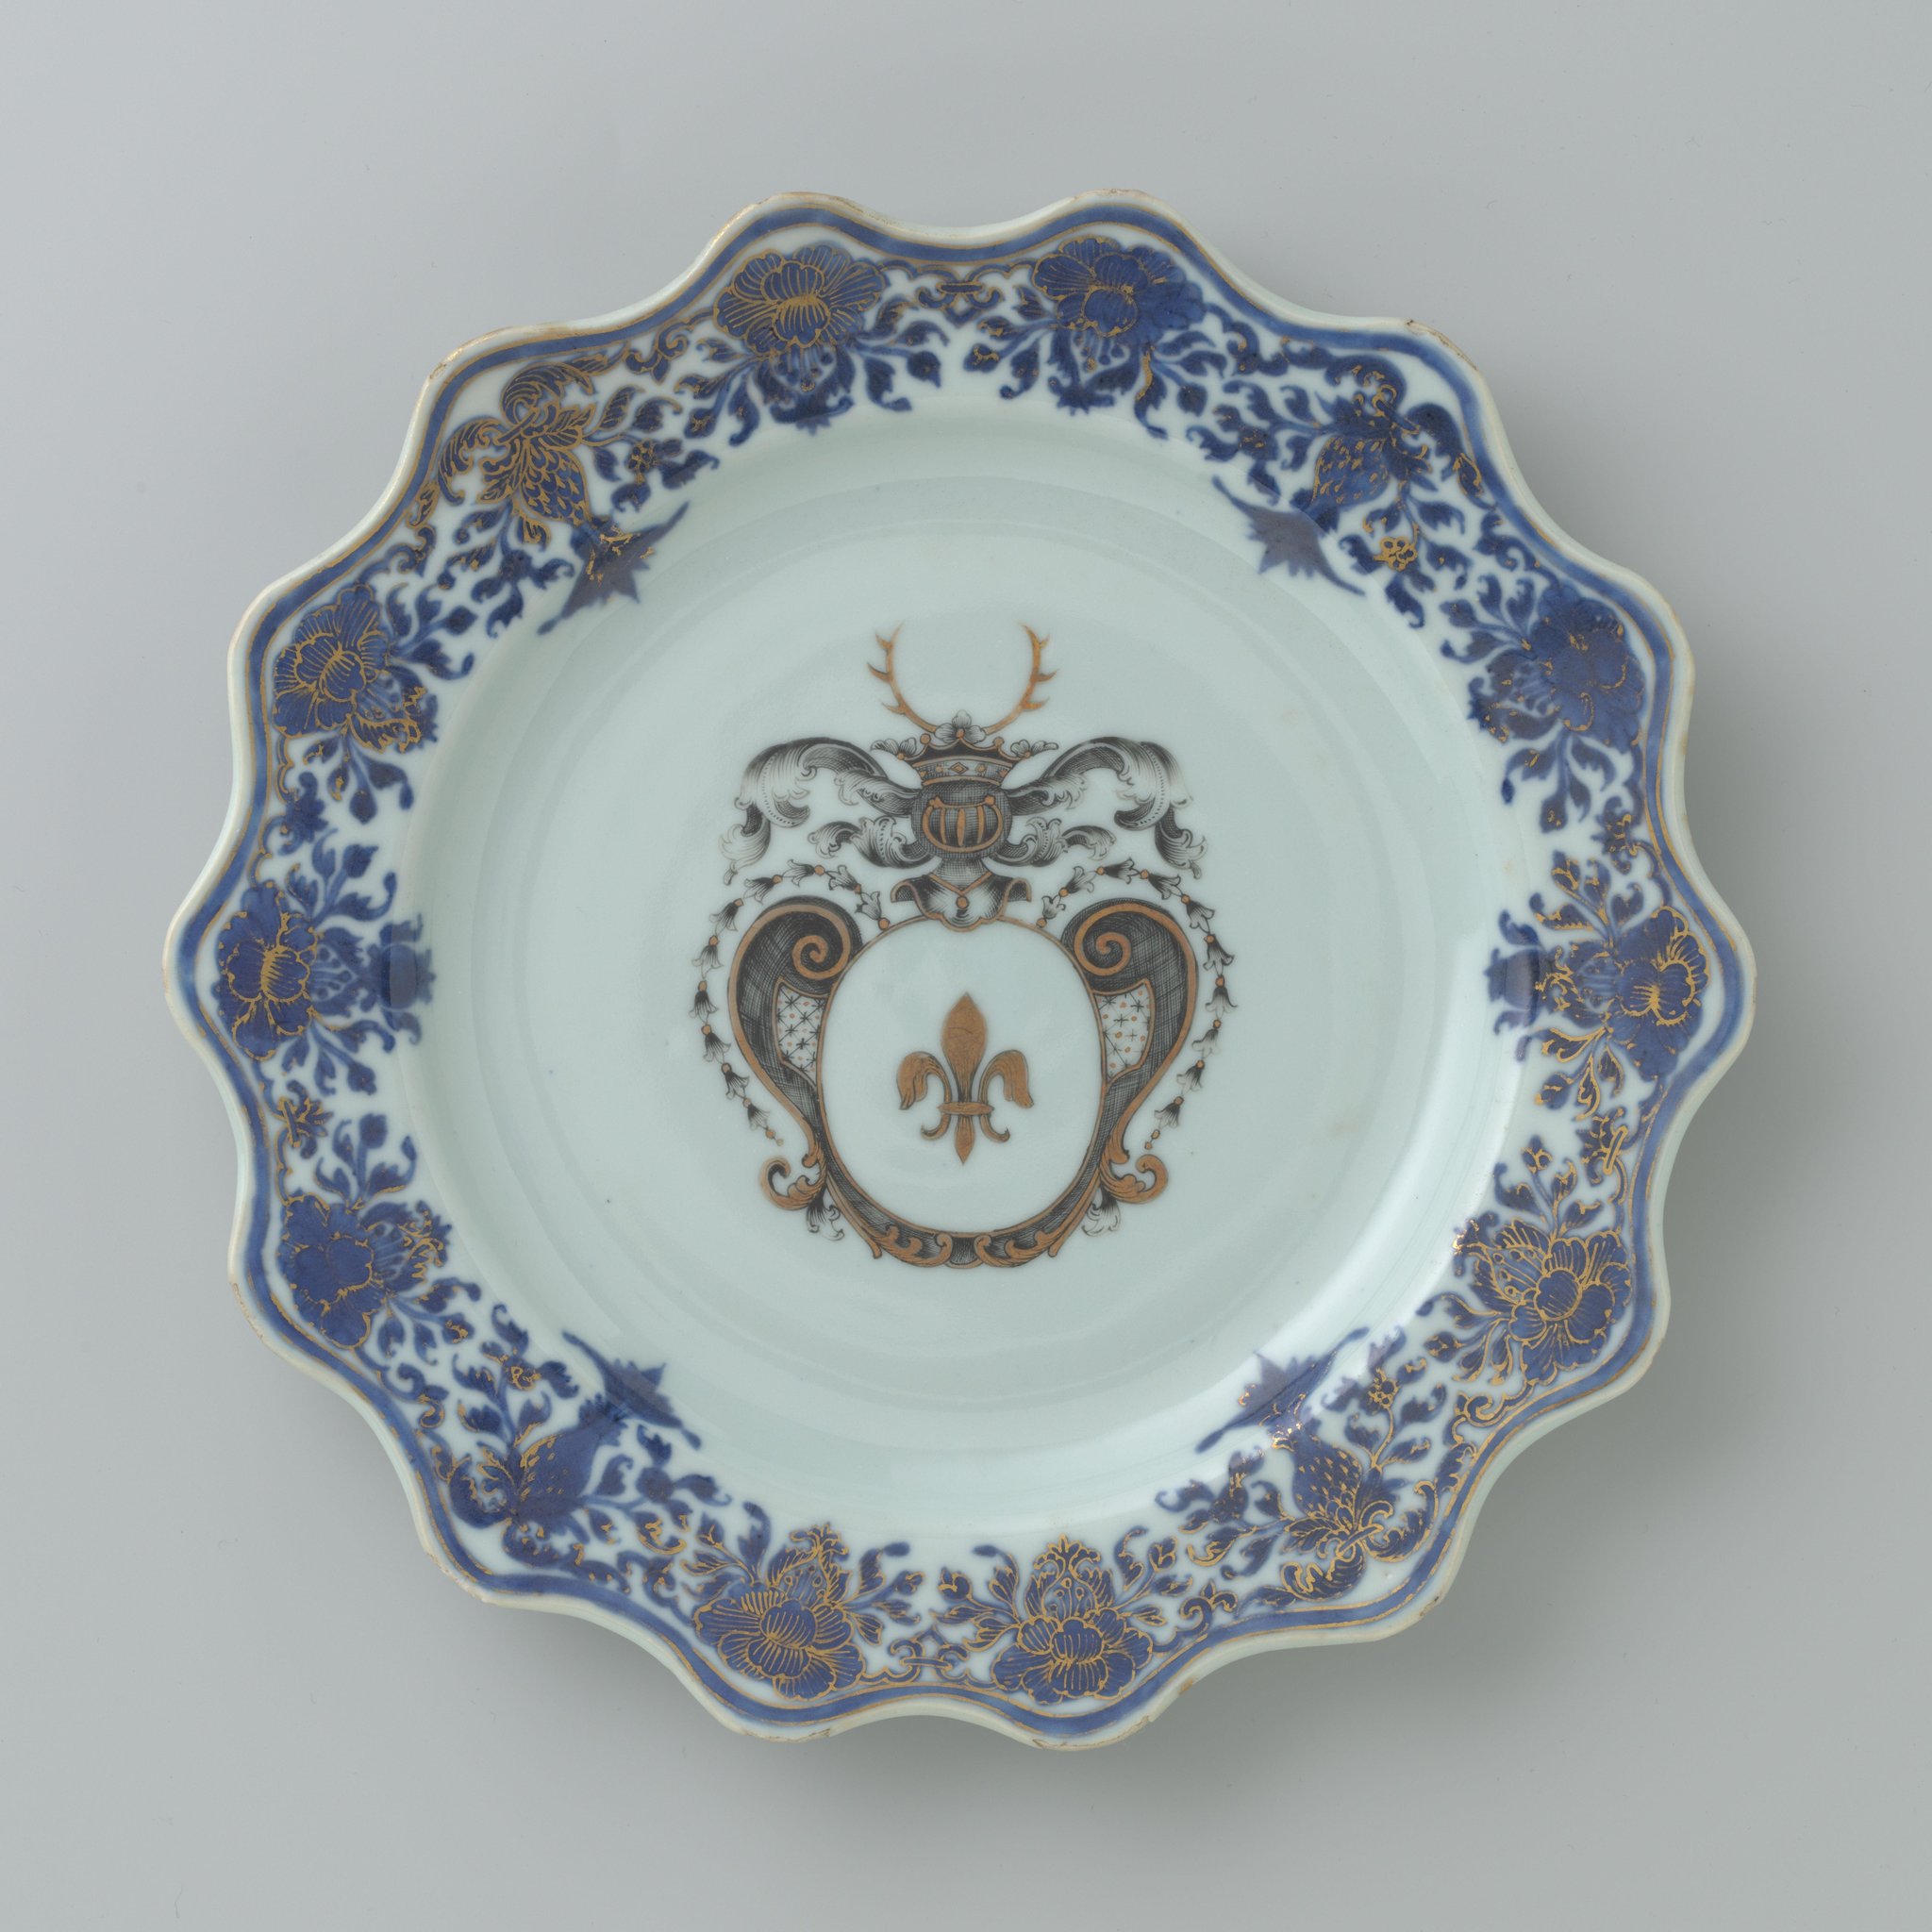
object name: plate dish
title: Dessertbord met het wapen van de familie Swellengrebel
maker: Anonymous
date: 1740-1750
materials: cobalt, glaze, gold, paint, porcelain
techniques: firing, gilding, turning, vitrification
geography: china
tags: utrecht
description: Klein bord op een standring en met een golvende rand. Beschilderd in onderglazuur blauw en met zwart en goud op het glazuur. Rond de rand een brede band met bandwerk en bloemranken in blauw met goudhet wapen van de familie Swellengrebel in zwart en goud: Franse lelie op een ovaal schild en een gewei boven een kroon als helmteken. Wapenporselein in blauw-wit en emailkleuren.